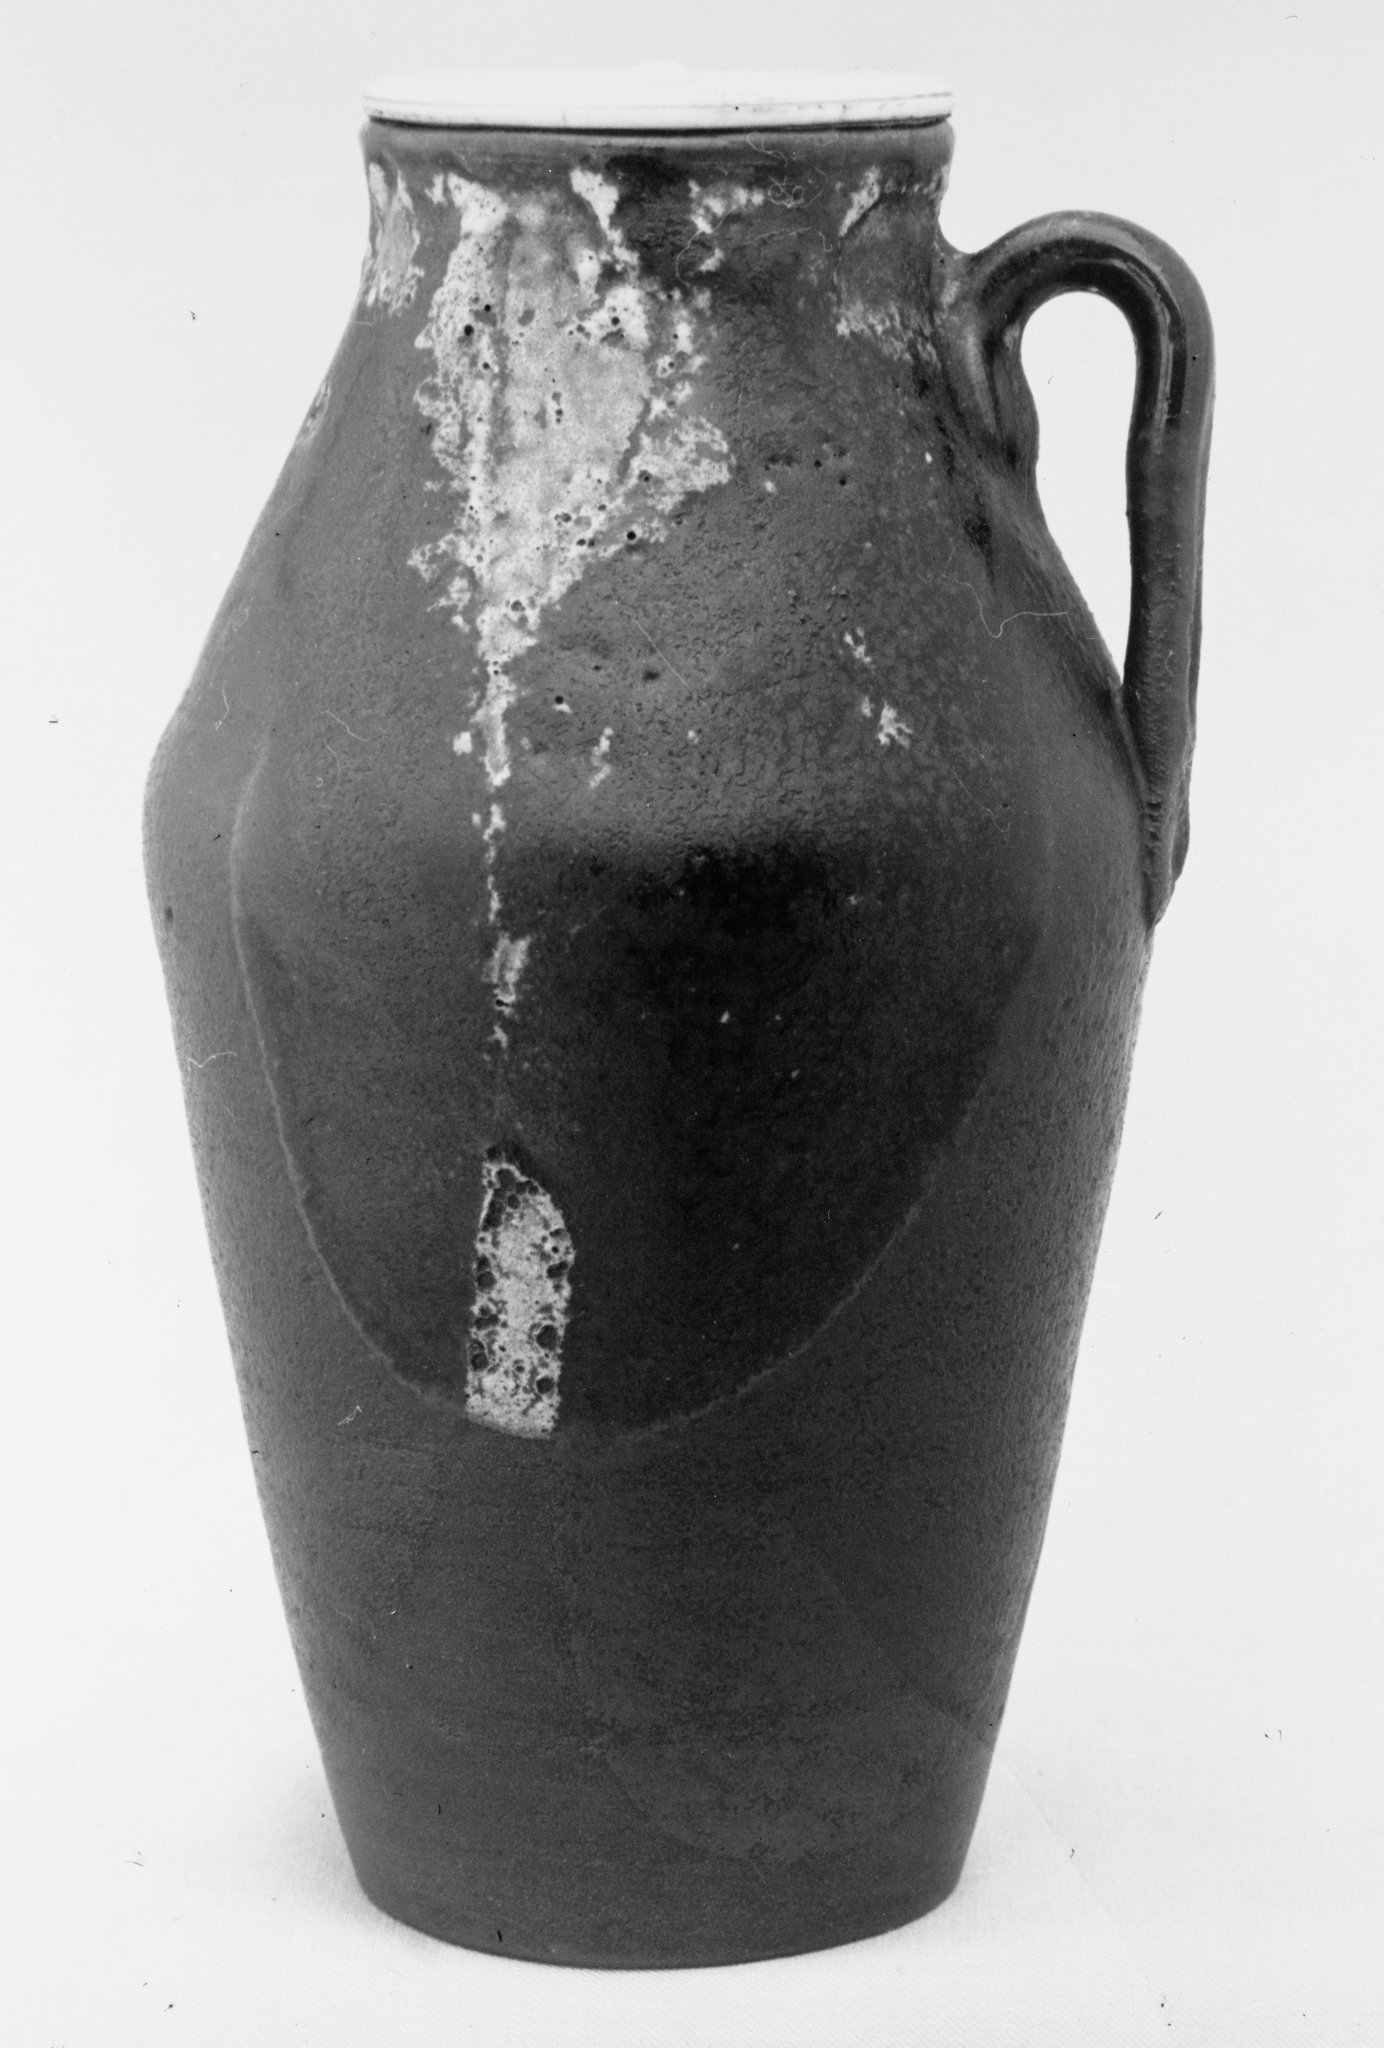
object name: tea jar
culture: japanese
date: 1701-1800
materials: clay, glaze